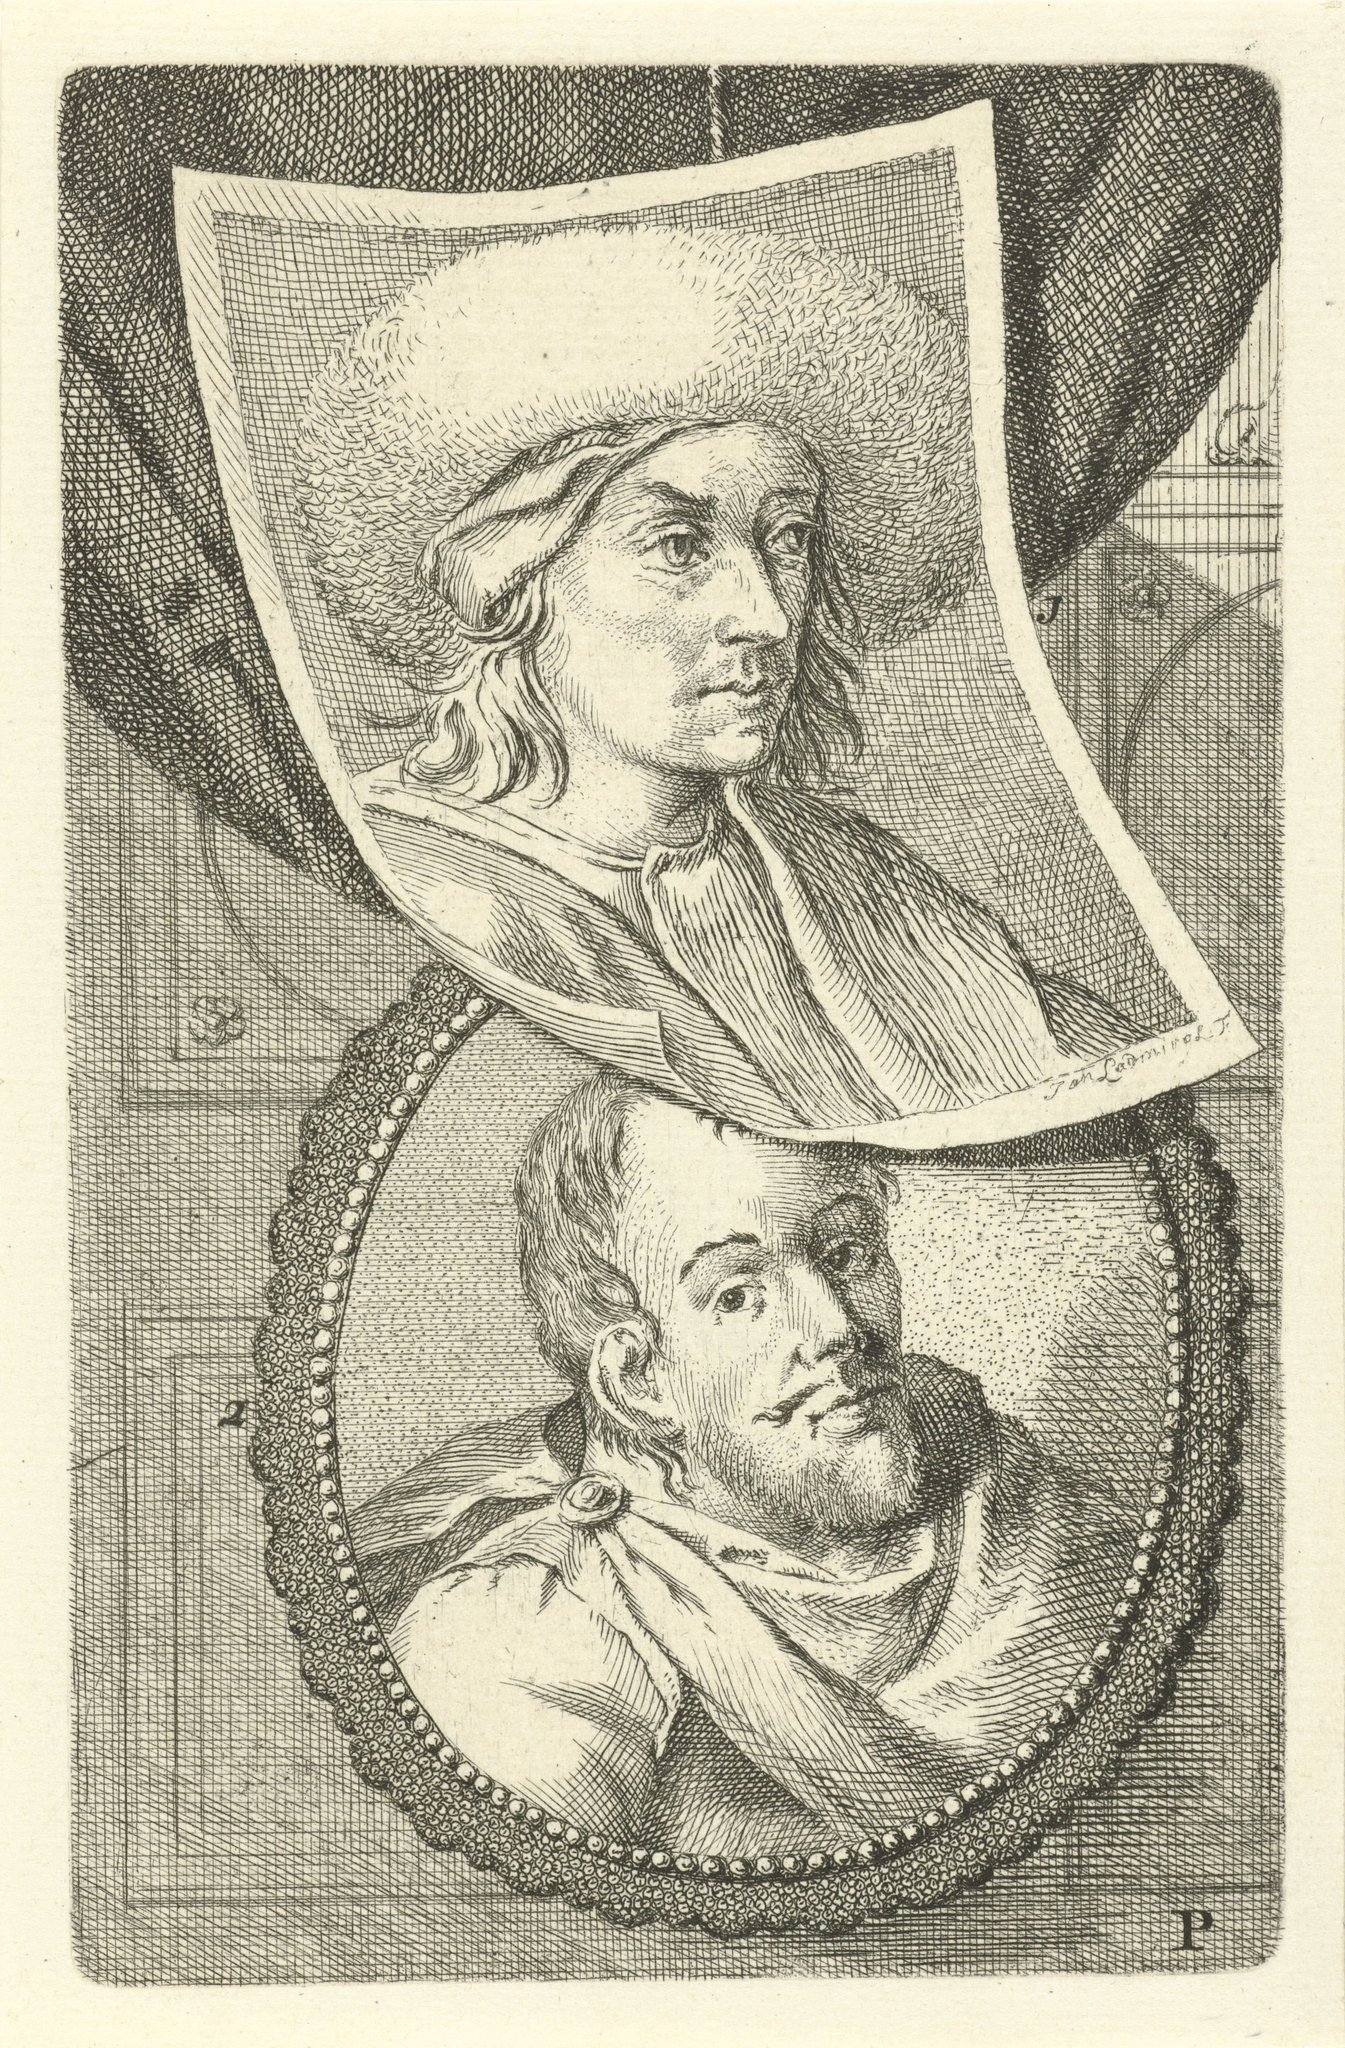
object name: print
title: Portretten van Jan Swart van Groningen en Jacob Janszen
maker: jan l admiral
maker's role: draughtsman, print maker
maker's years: 1699-1773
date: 1764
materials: paper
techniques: etching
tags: antwerp, painter, print maker, draughtsman, jan swart van groningen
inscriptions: collector's mark: Lugt 2228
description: Prent opgenomen in: Mander, Karel van; Jongh, Jacobus de (vert.). Het leven der doorluchtige Nederlandsche en eenige Hoogduitsche schilders. Amsterdam: Steven van Esveldt, 1764.